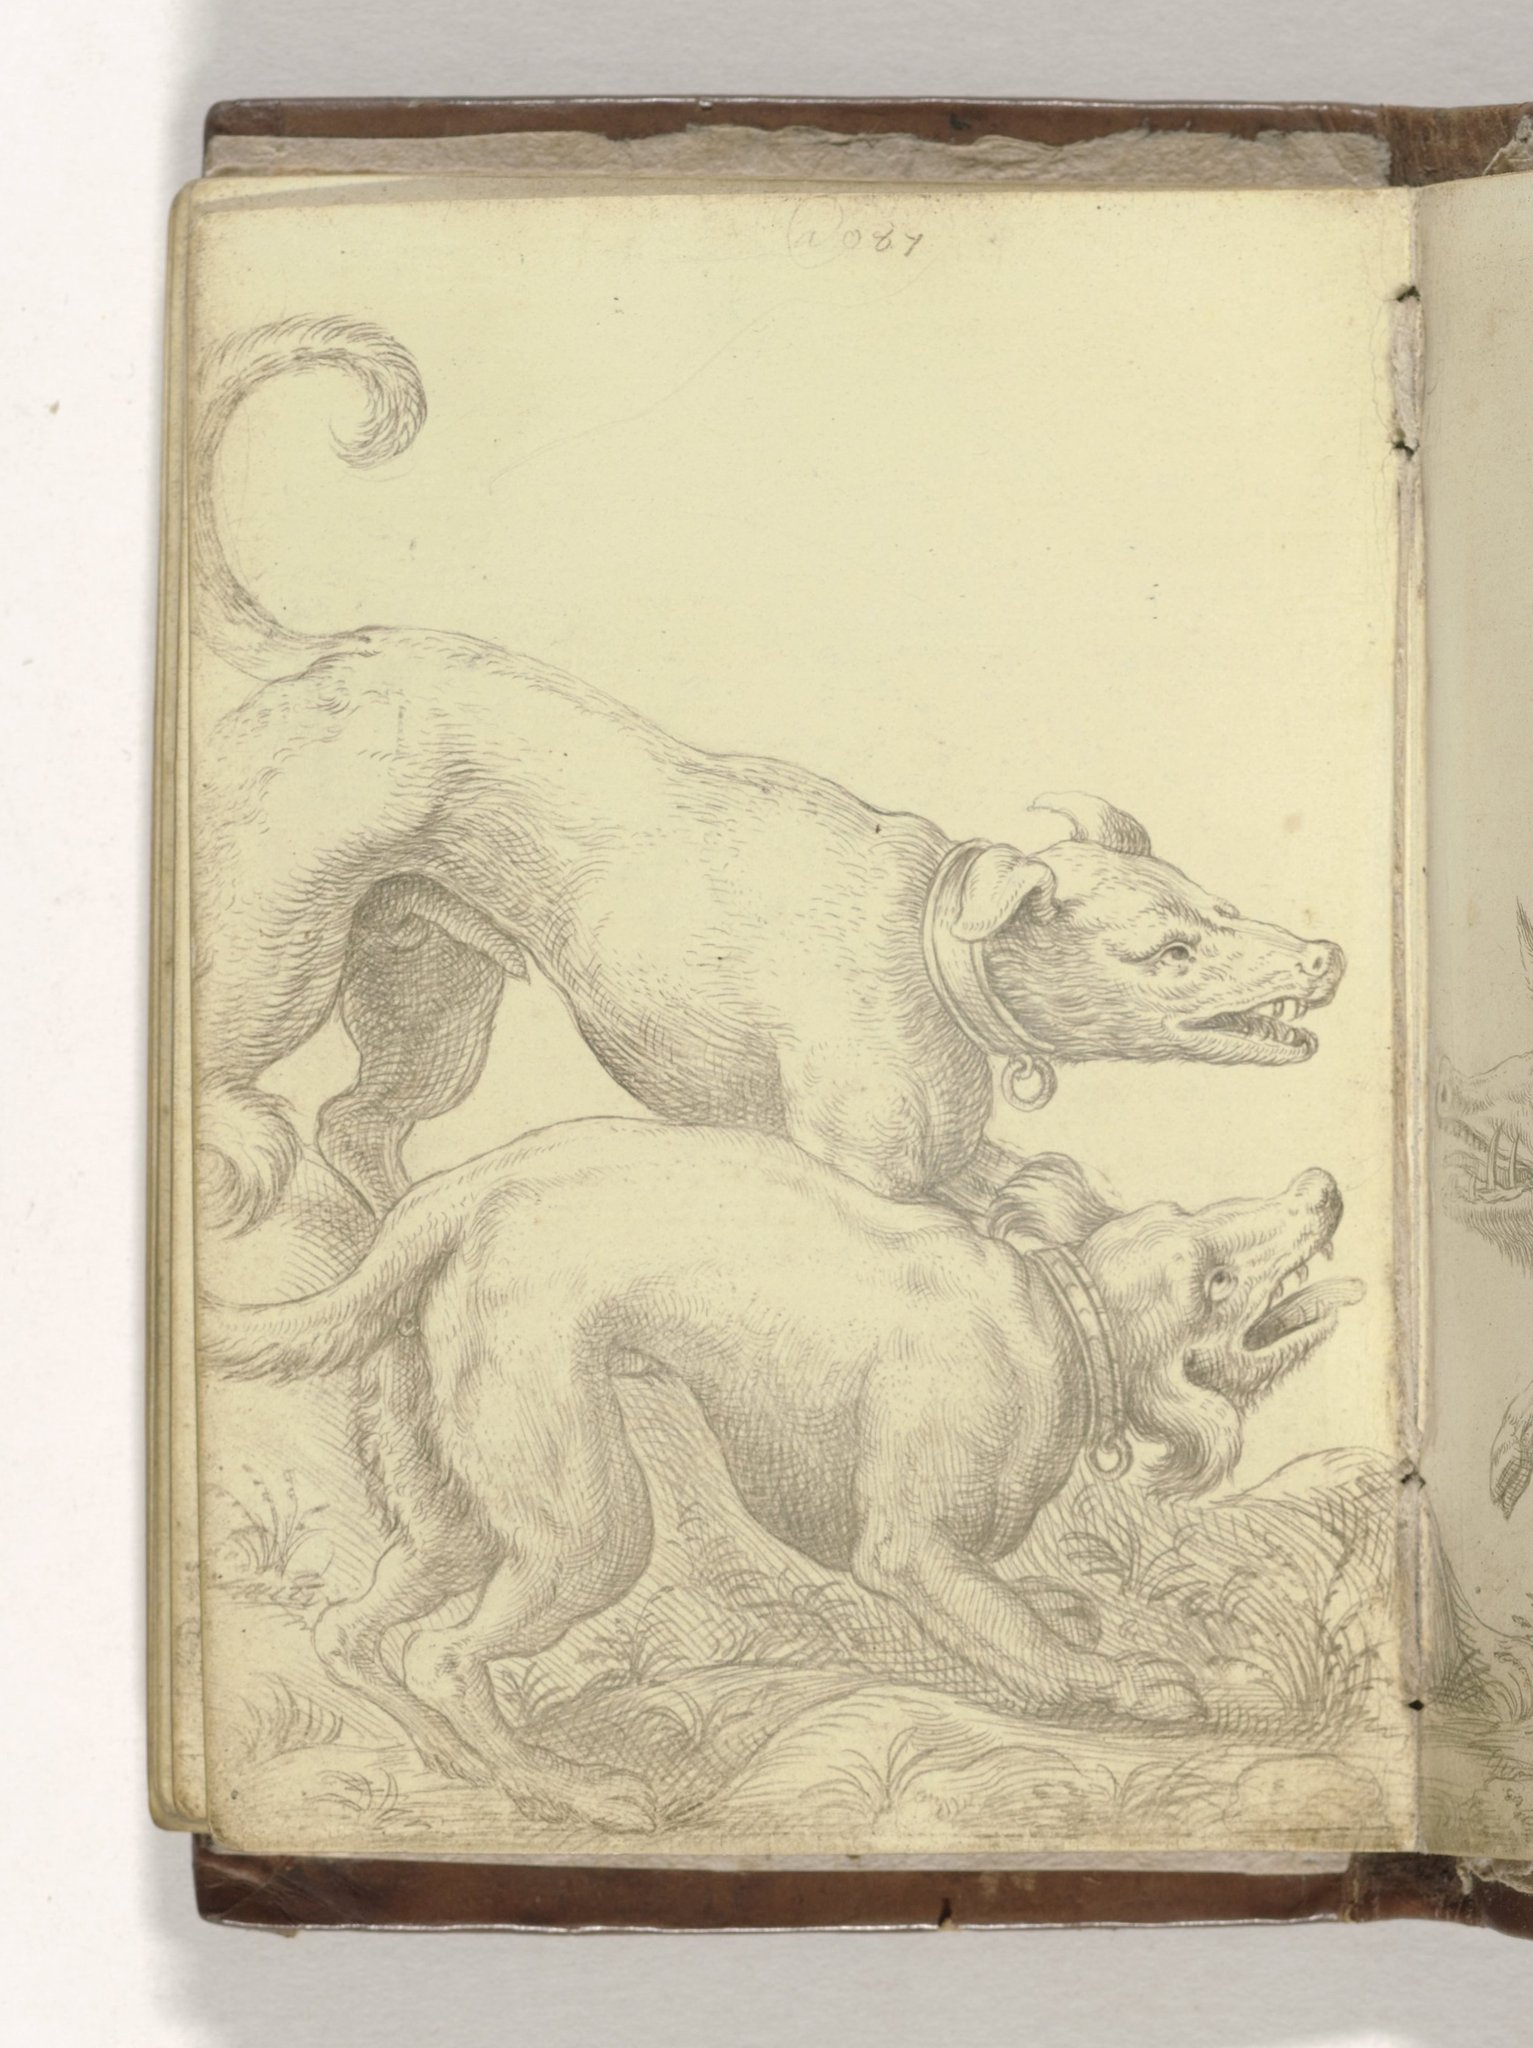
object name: drawing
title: Twee honden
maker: Anonymous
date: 1586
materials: paper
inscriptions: date: ‘1586’